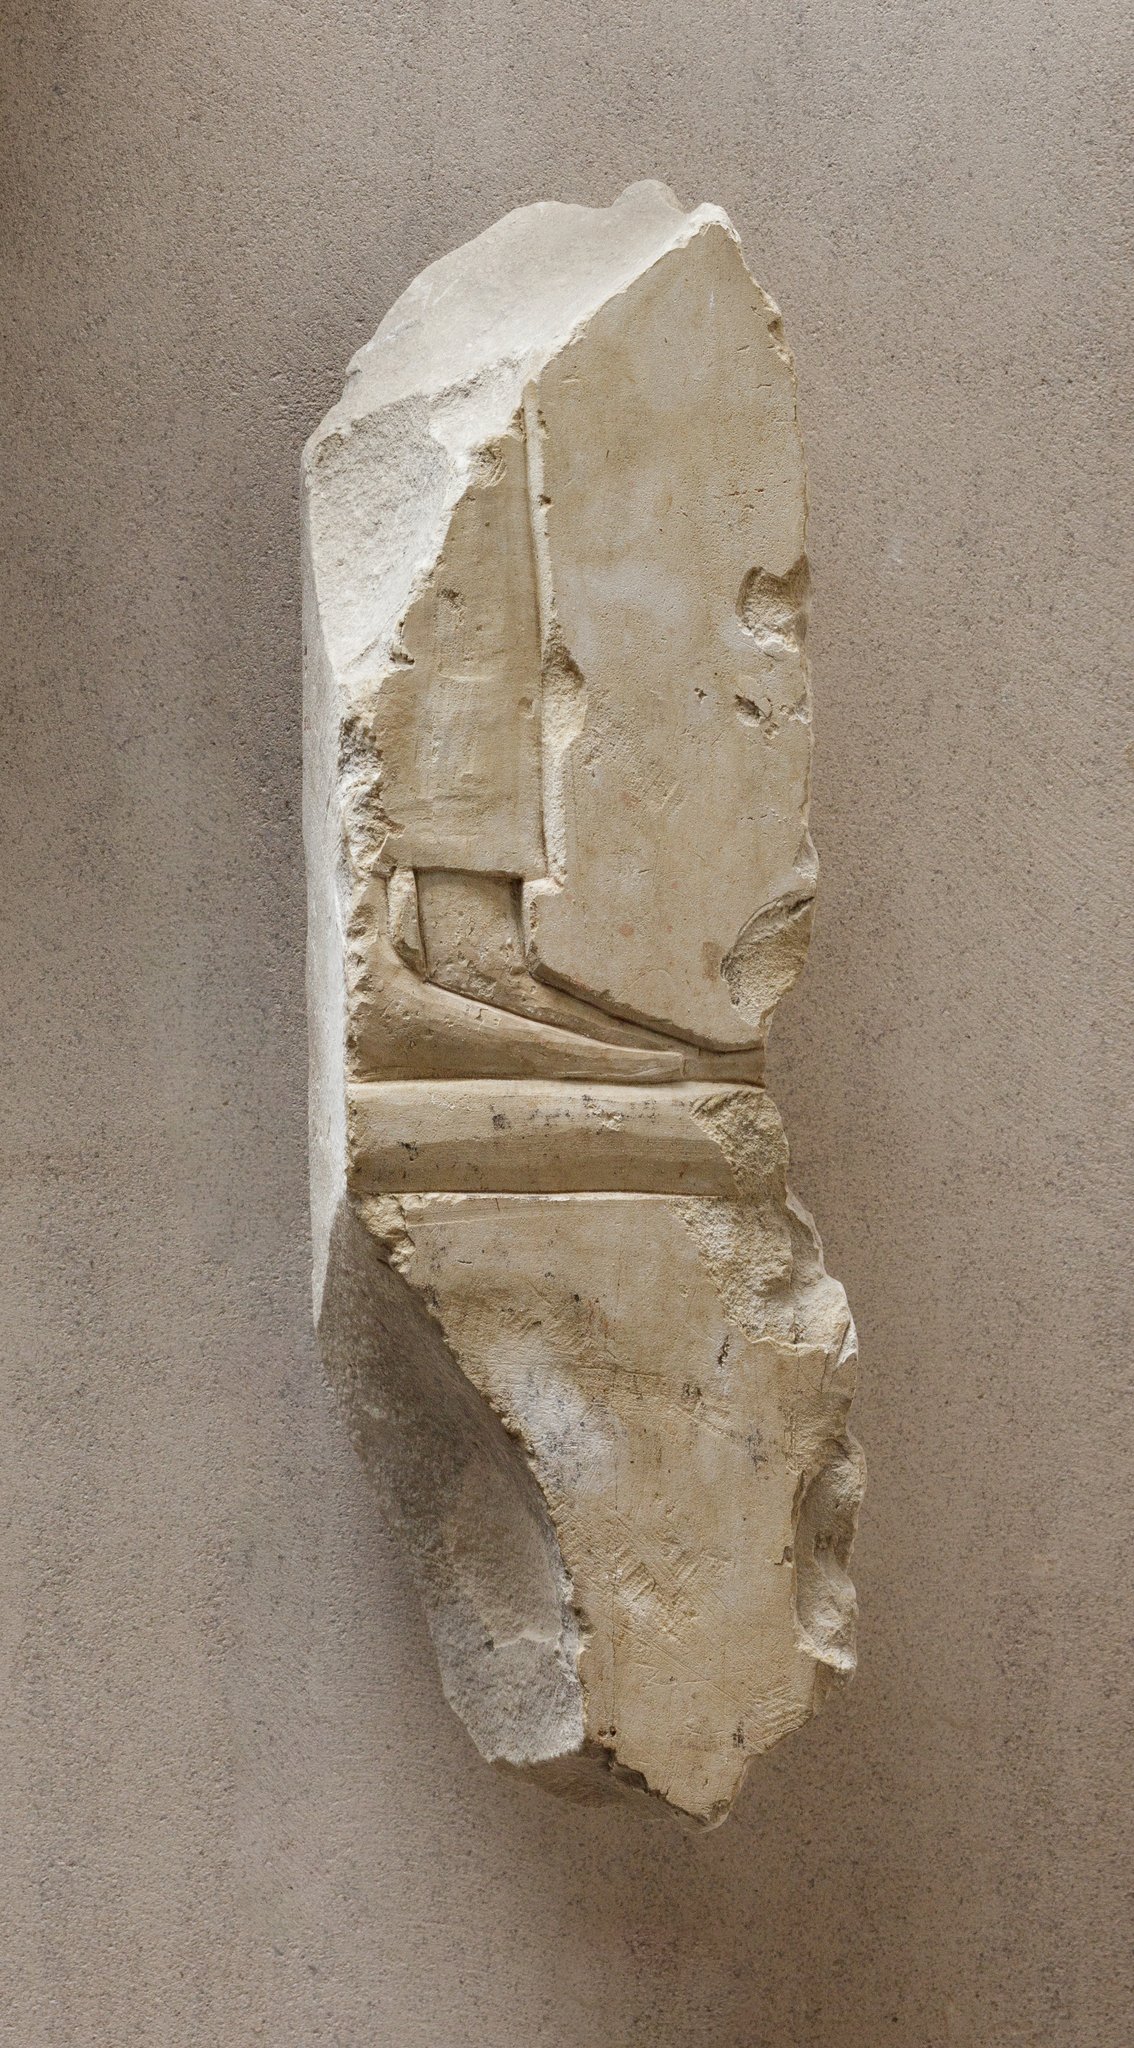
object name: relief fragment, tomb of neferu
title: Relief fragment from a procession of attendants - see 31.3.1-1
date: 2051-2030 BCE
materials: limestone, paint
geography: egypt